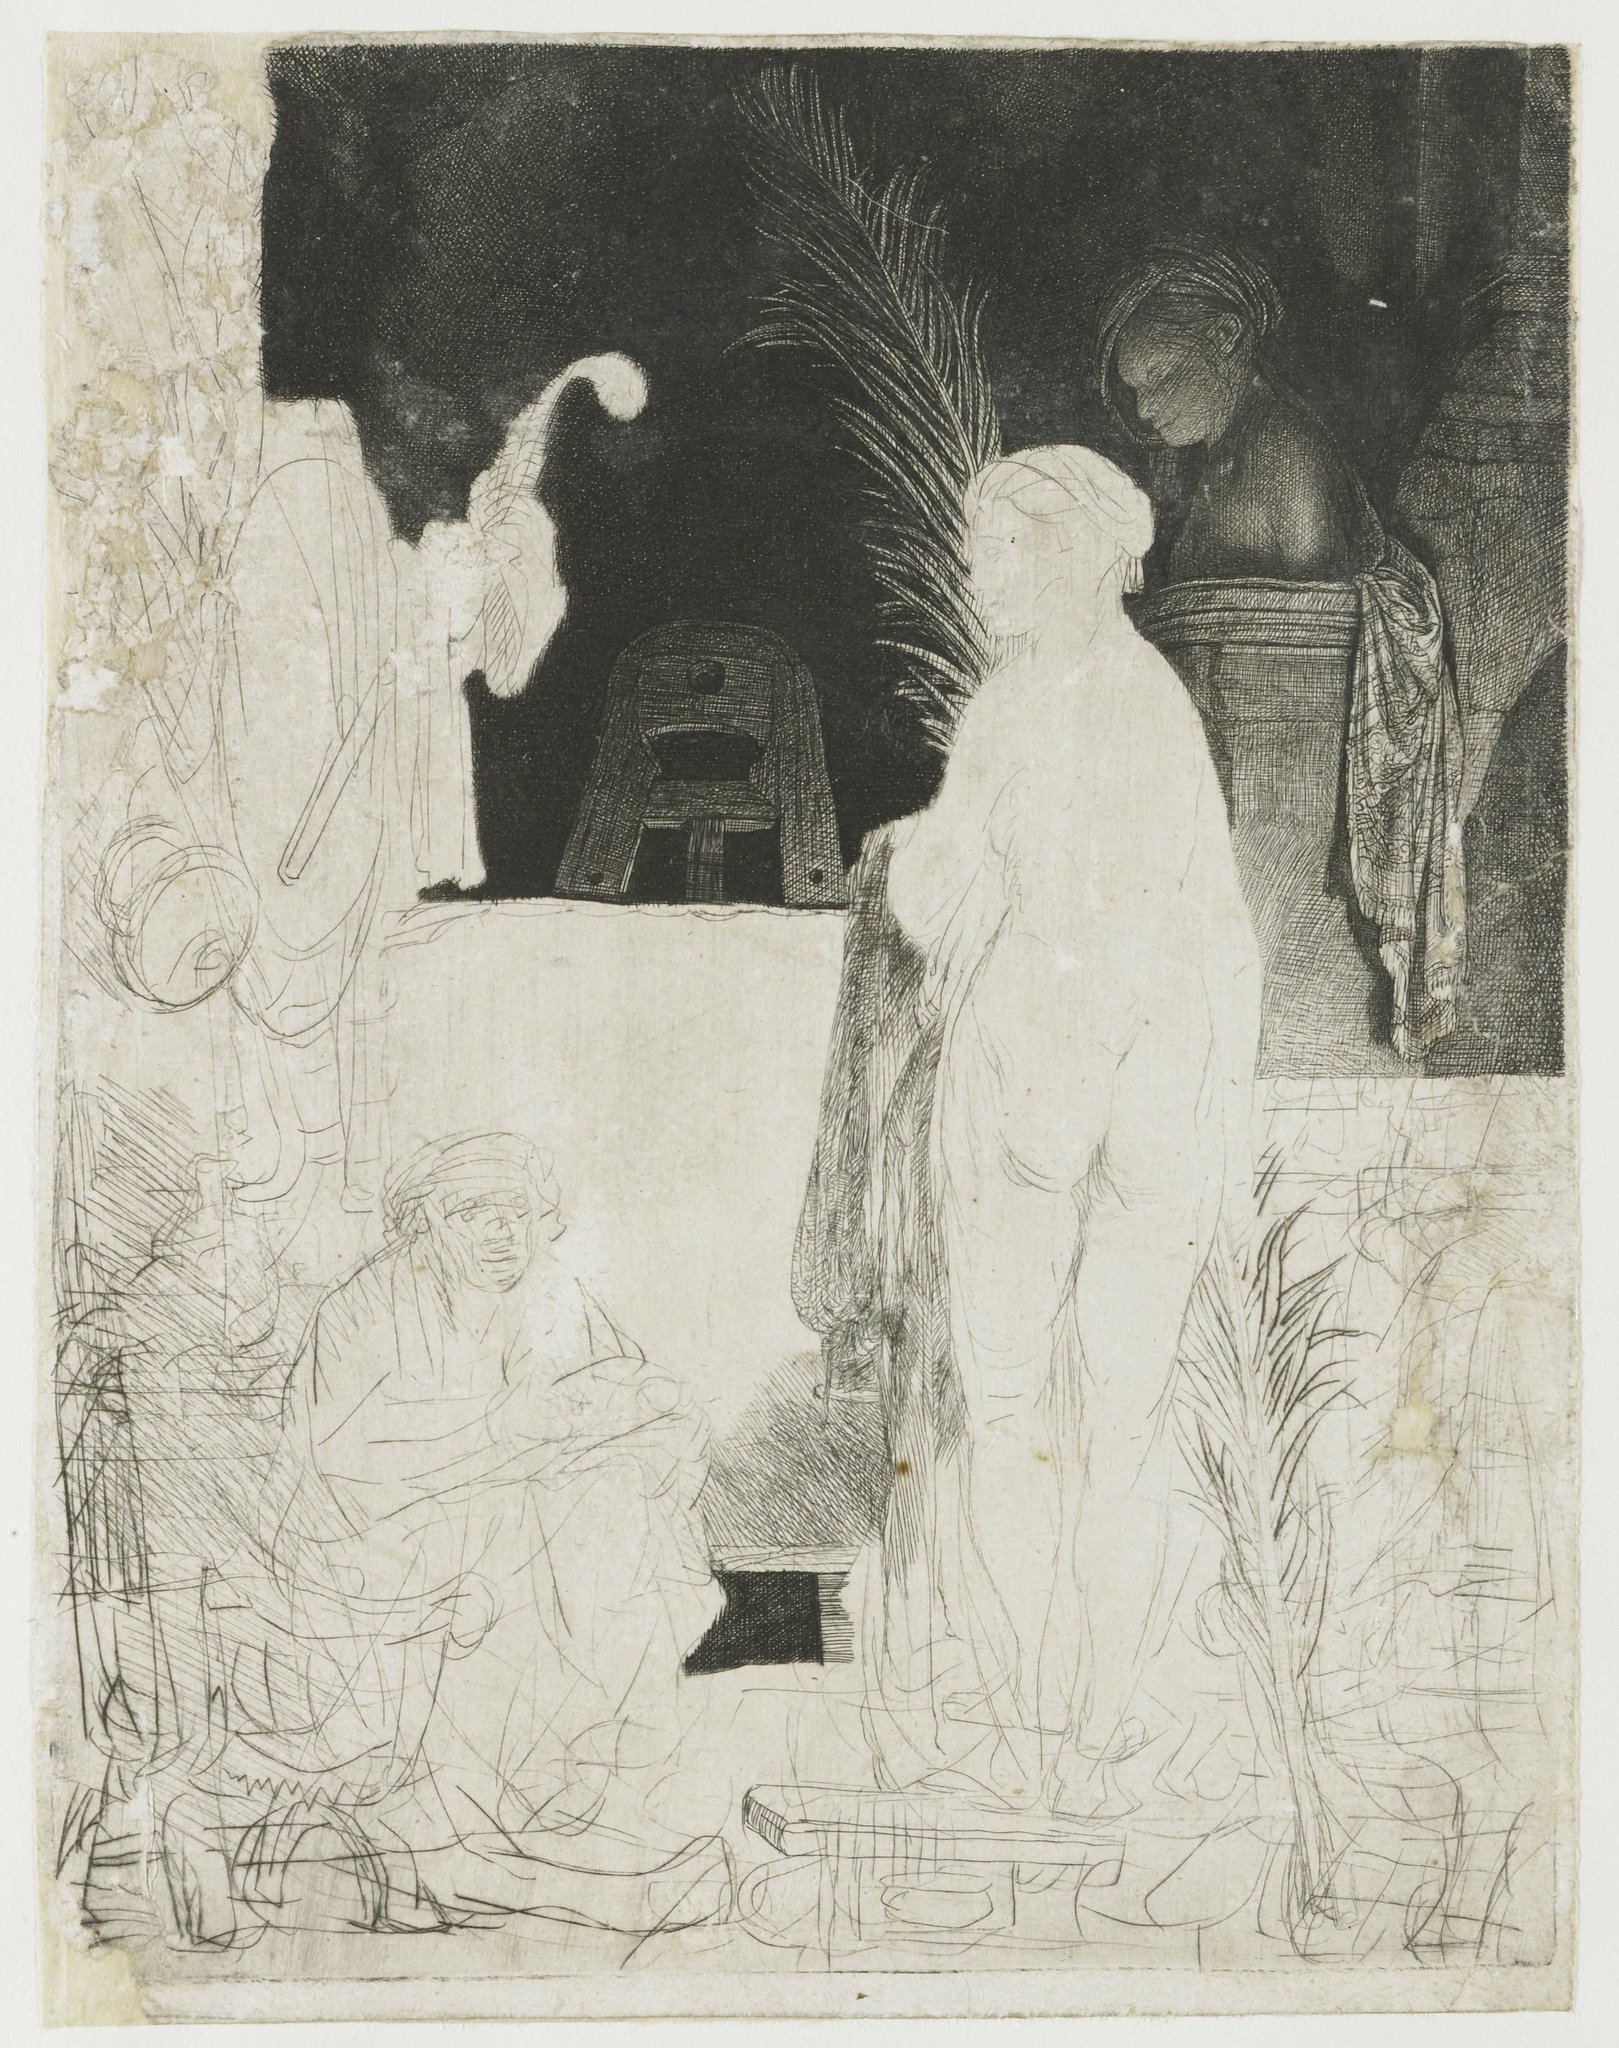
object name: print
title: The artist drawing from the model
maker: rembrandt van rijn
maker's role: draughtsman, painter, print maker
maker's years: 1606-1669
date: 1639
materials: paper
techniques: drypoint, etching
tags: artist (in general) working from live model